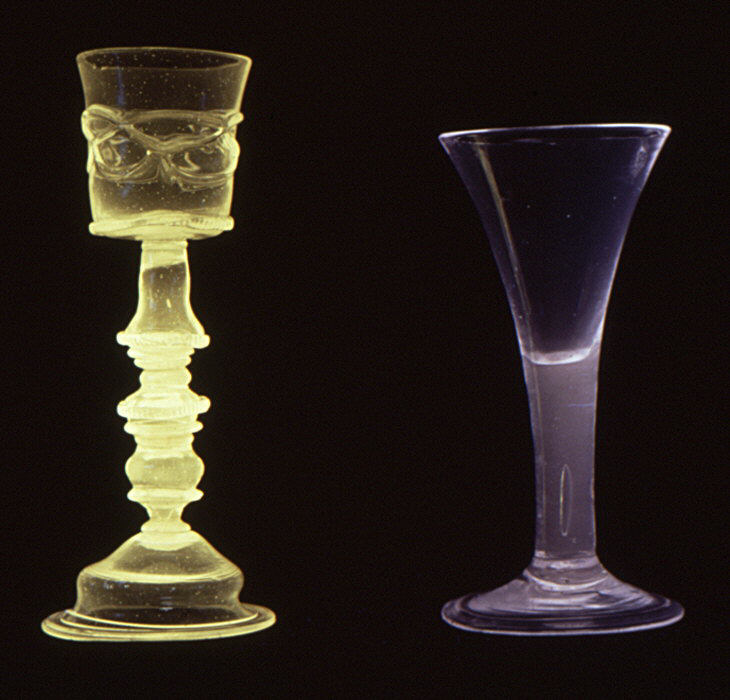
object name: chalice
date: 1701-1800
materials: glass